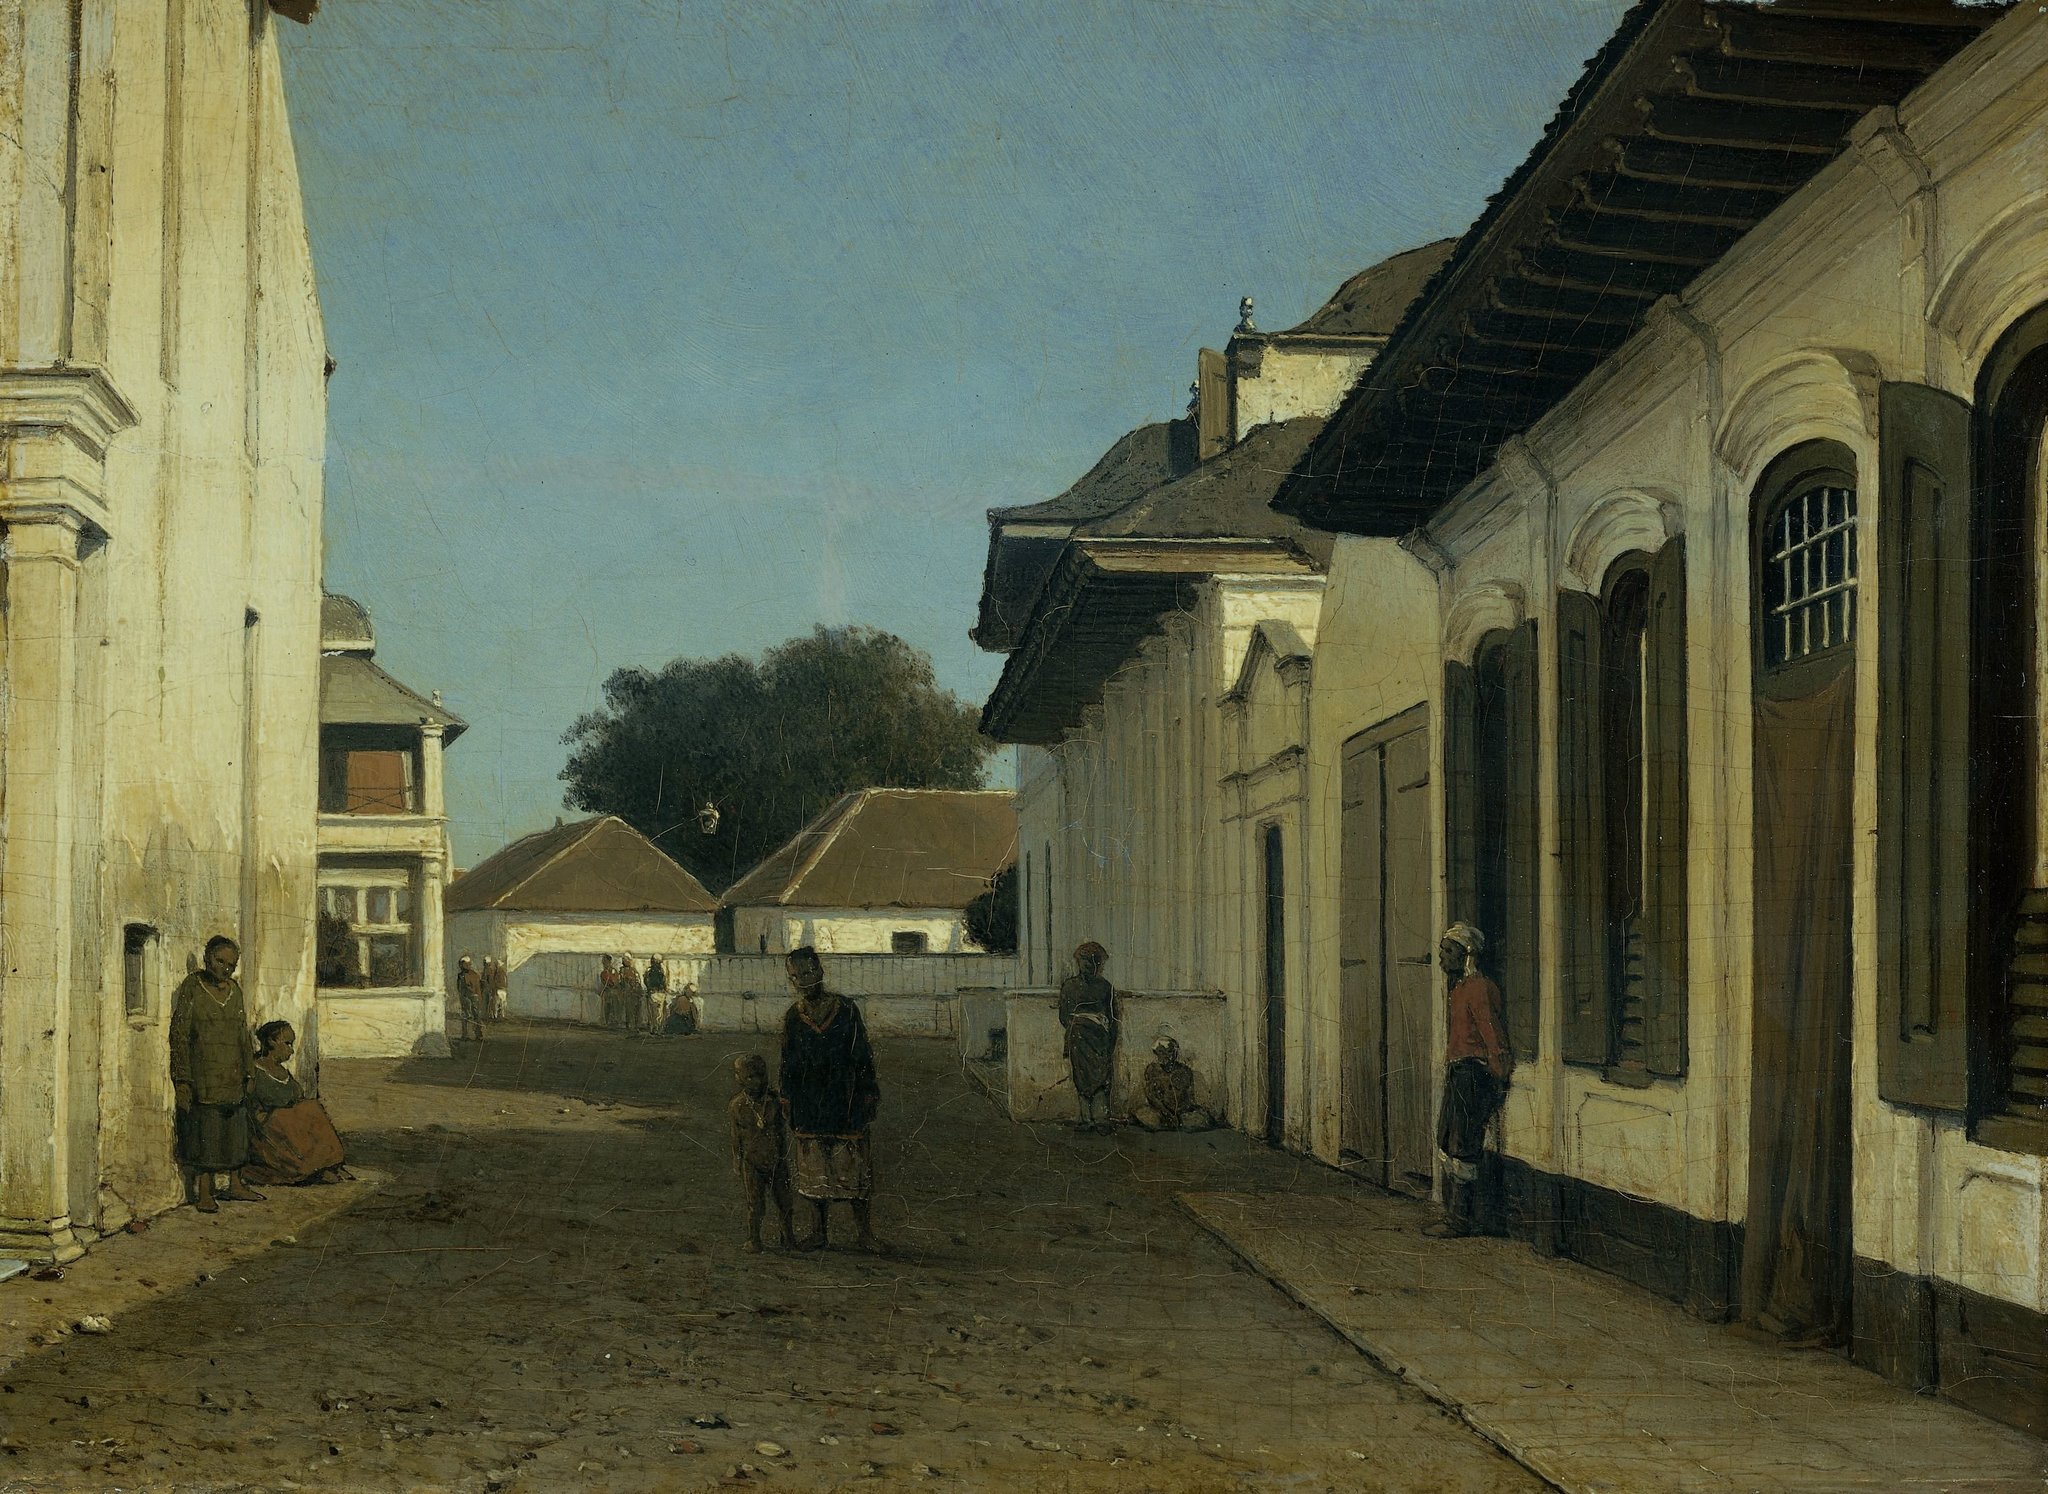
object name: painting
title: Een straat in het oude deel van Batavia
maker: jan weissenbruch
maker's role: painter, print maker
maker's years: 1822-1880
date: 1860-1880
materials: oil, panel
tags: factories and mills in landscape, batavia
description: Een straatje in het oude gedeelte van Batavia, op straat en leunend tegen de muren enkele inlanders.